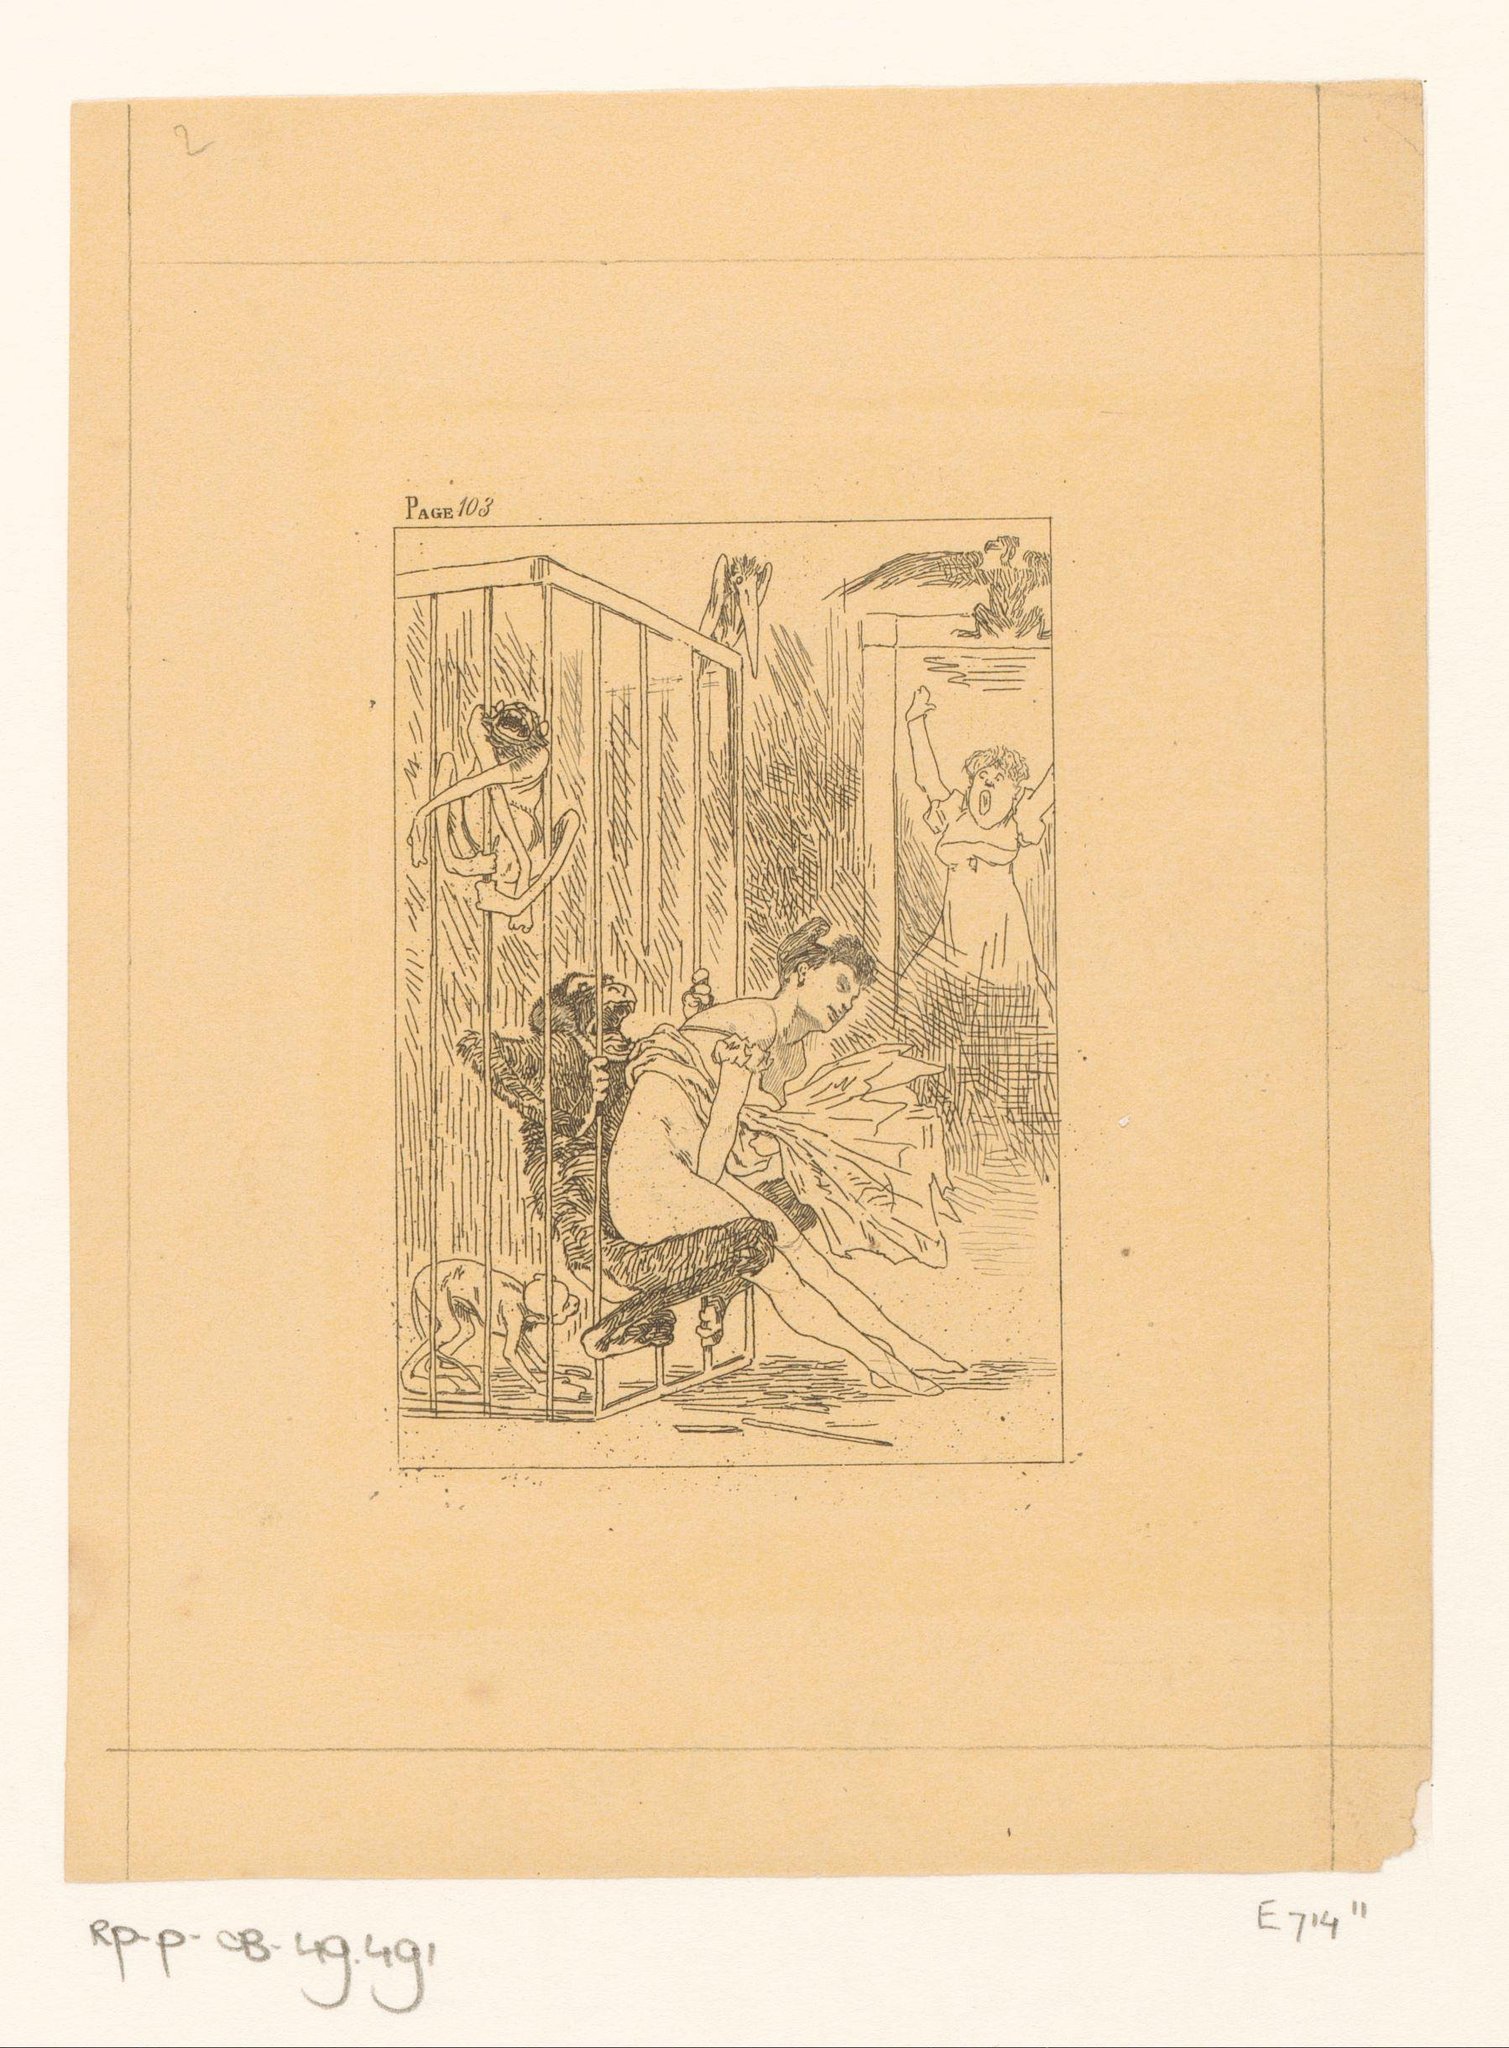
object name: print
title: Mensaap copuleert met een vrouw door de spijlen van zijn kooi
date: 1864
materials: paper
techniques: etching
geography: paris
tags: adult woman, monkeys, apes, sodomy, sexual contact between humans and animals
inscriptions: collector's mark: Lugt 2228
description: Prent uit: Musset, Alfred de. Gamiani ou deux nuits d'excès. Parijs: Poulet-Malassis, 1864, p. 103.